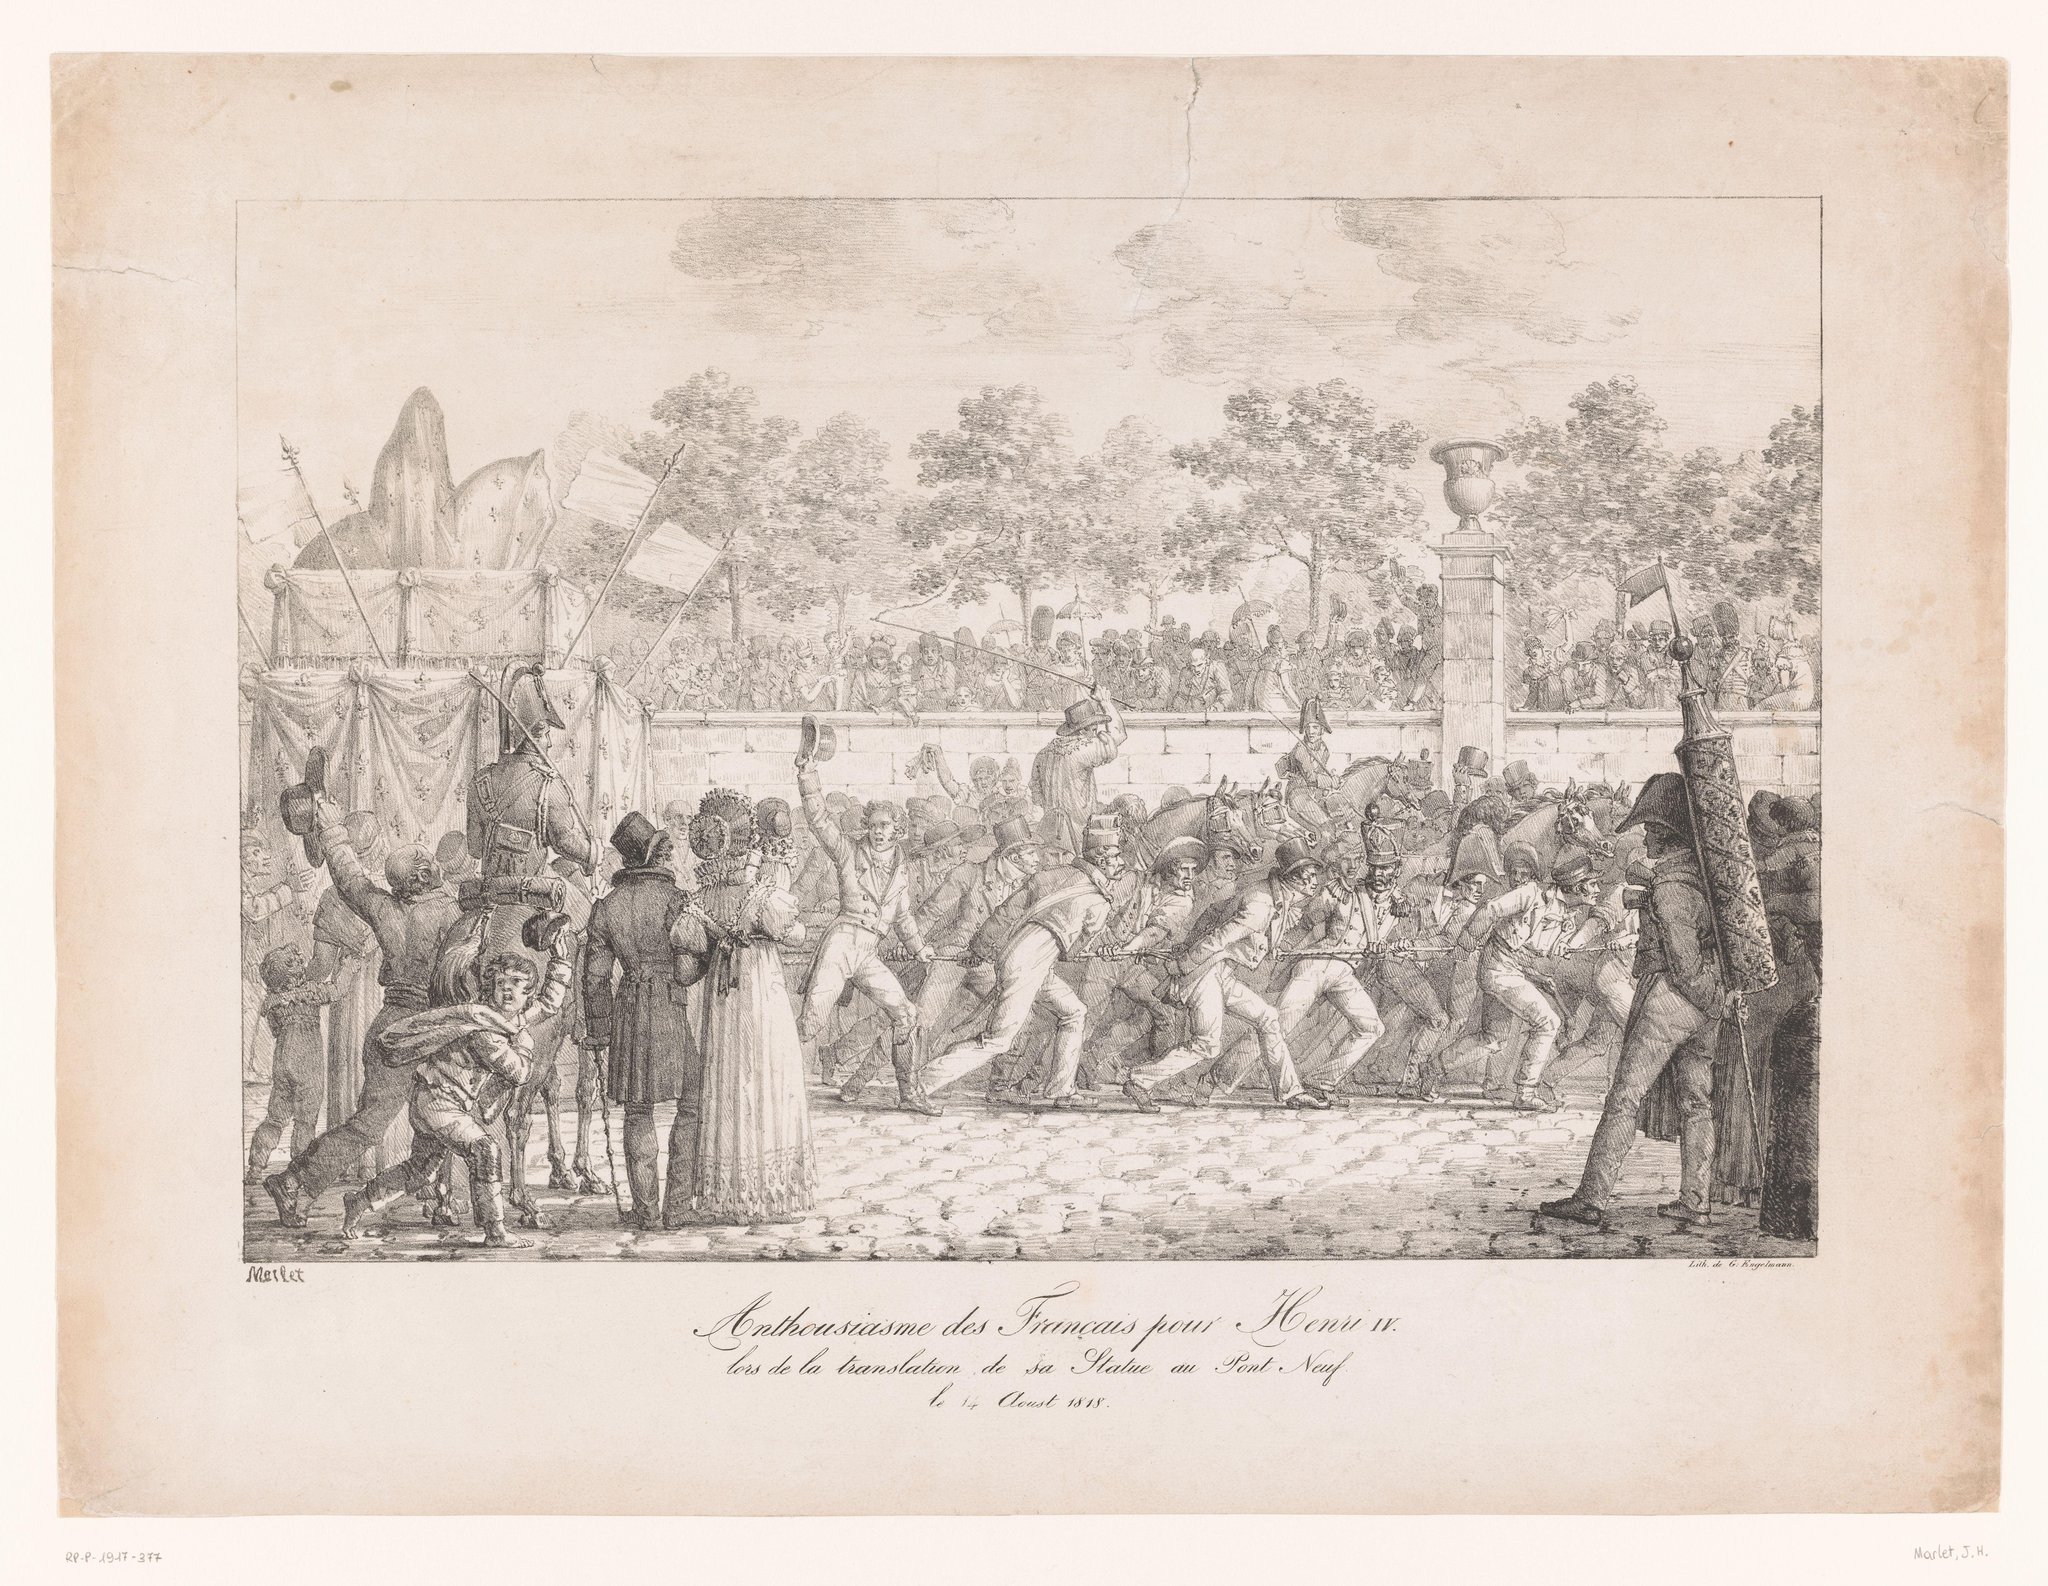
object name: print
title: Anthousiasme des Français pour Henri IV. lors de la translation, de sa statue au pont Neuf. le 14 aout 1818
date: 1818-1839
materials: paper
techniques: lithograph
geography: france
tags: drawing, pulling something, crowd, mob, historical events and situations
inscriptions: check stamp:, collector's mark: Lugt 2233